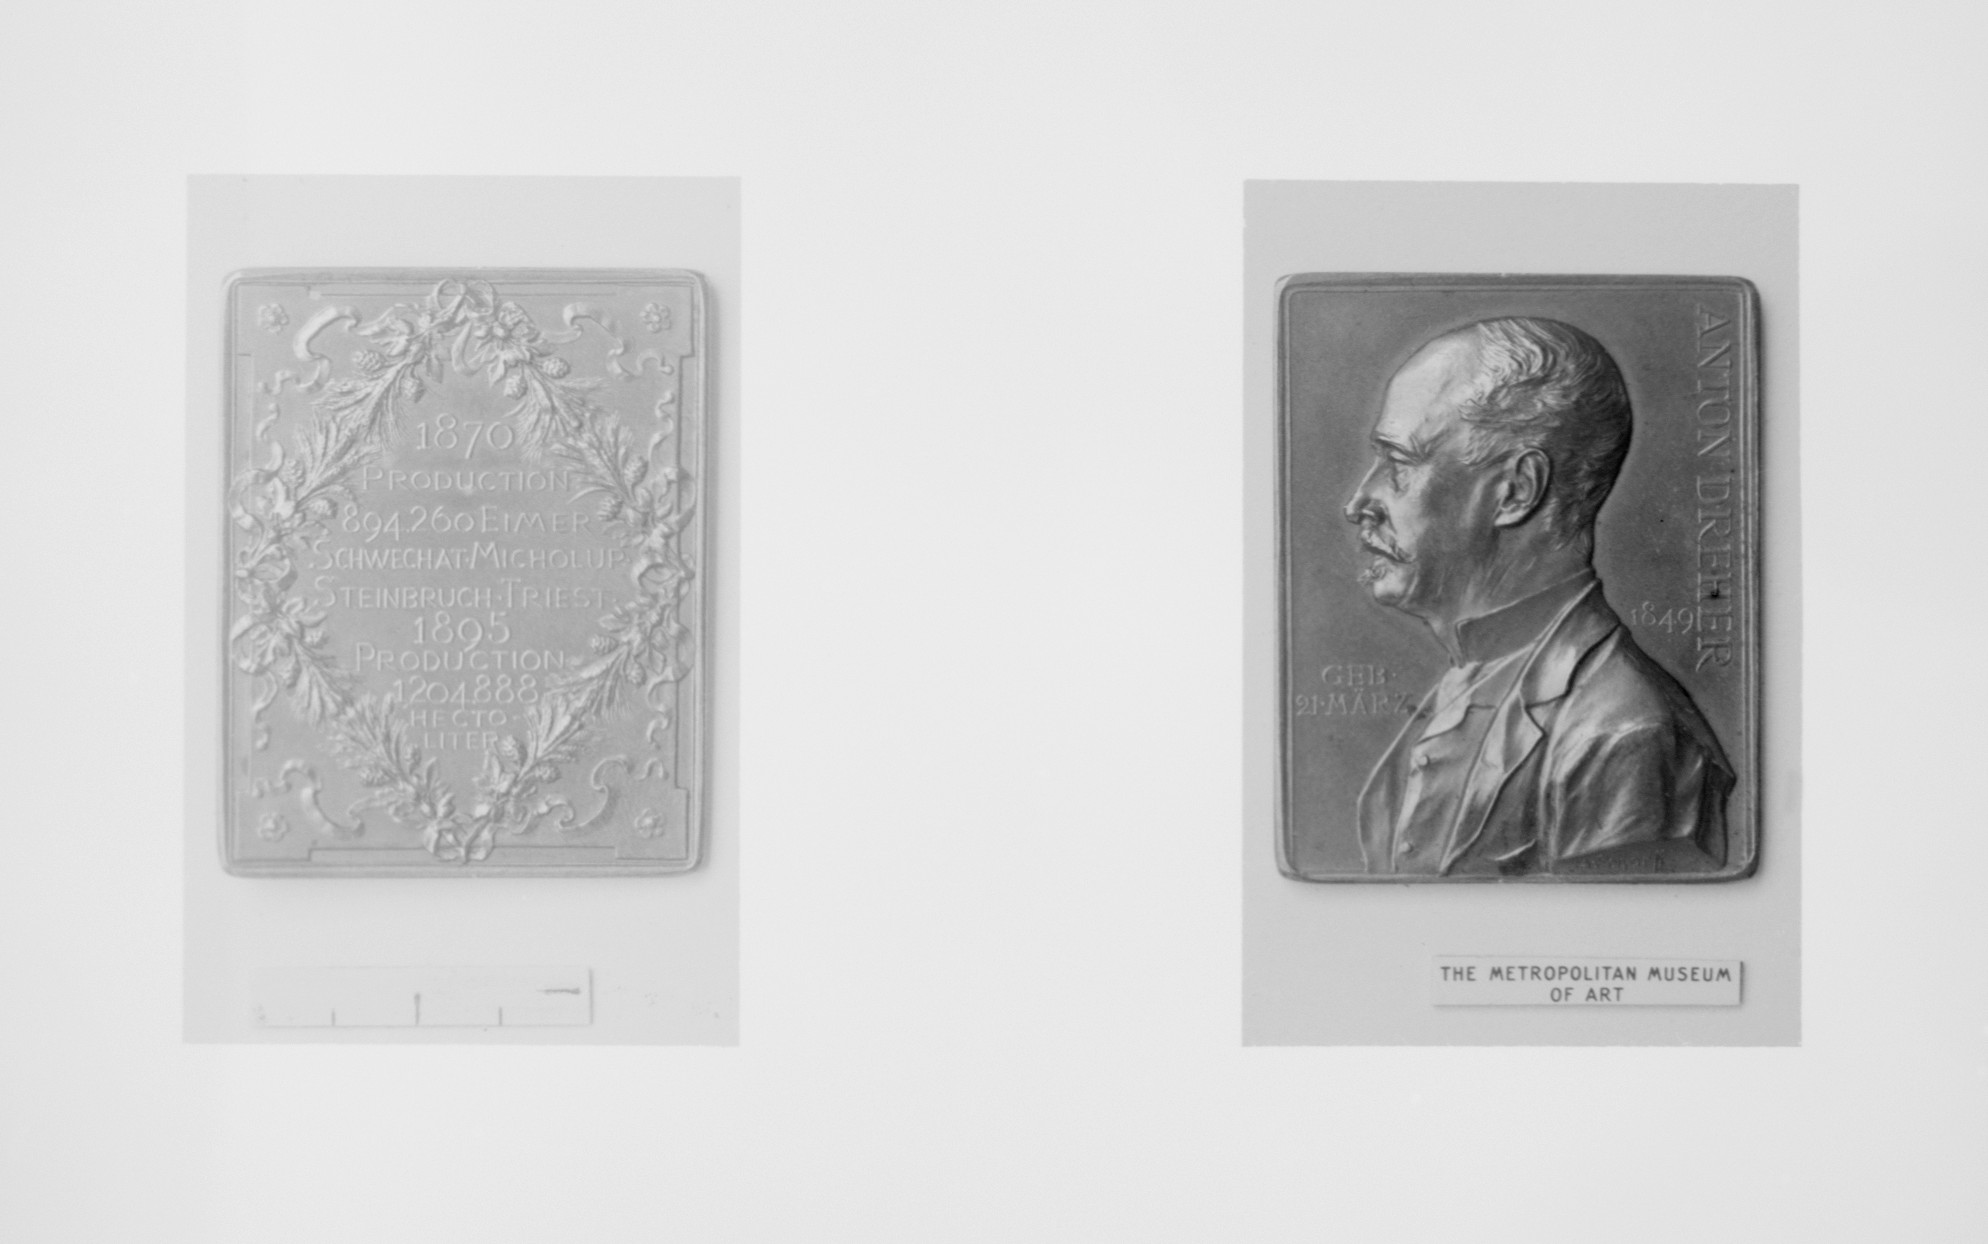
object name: plaquette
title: Portrait of Anton Dreher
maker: anton scharff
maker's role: artist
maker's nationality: austrian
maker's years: 1845-1903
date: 1895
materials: bronze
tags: men,portraits